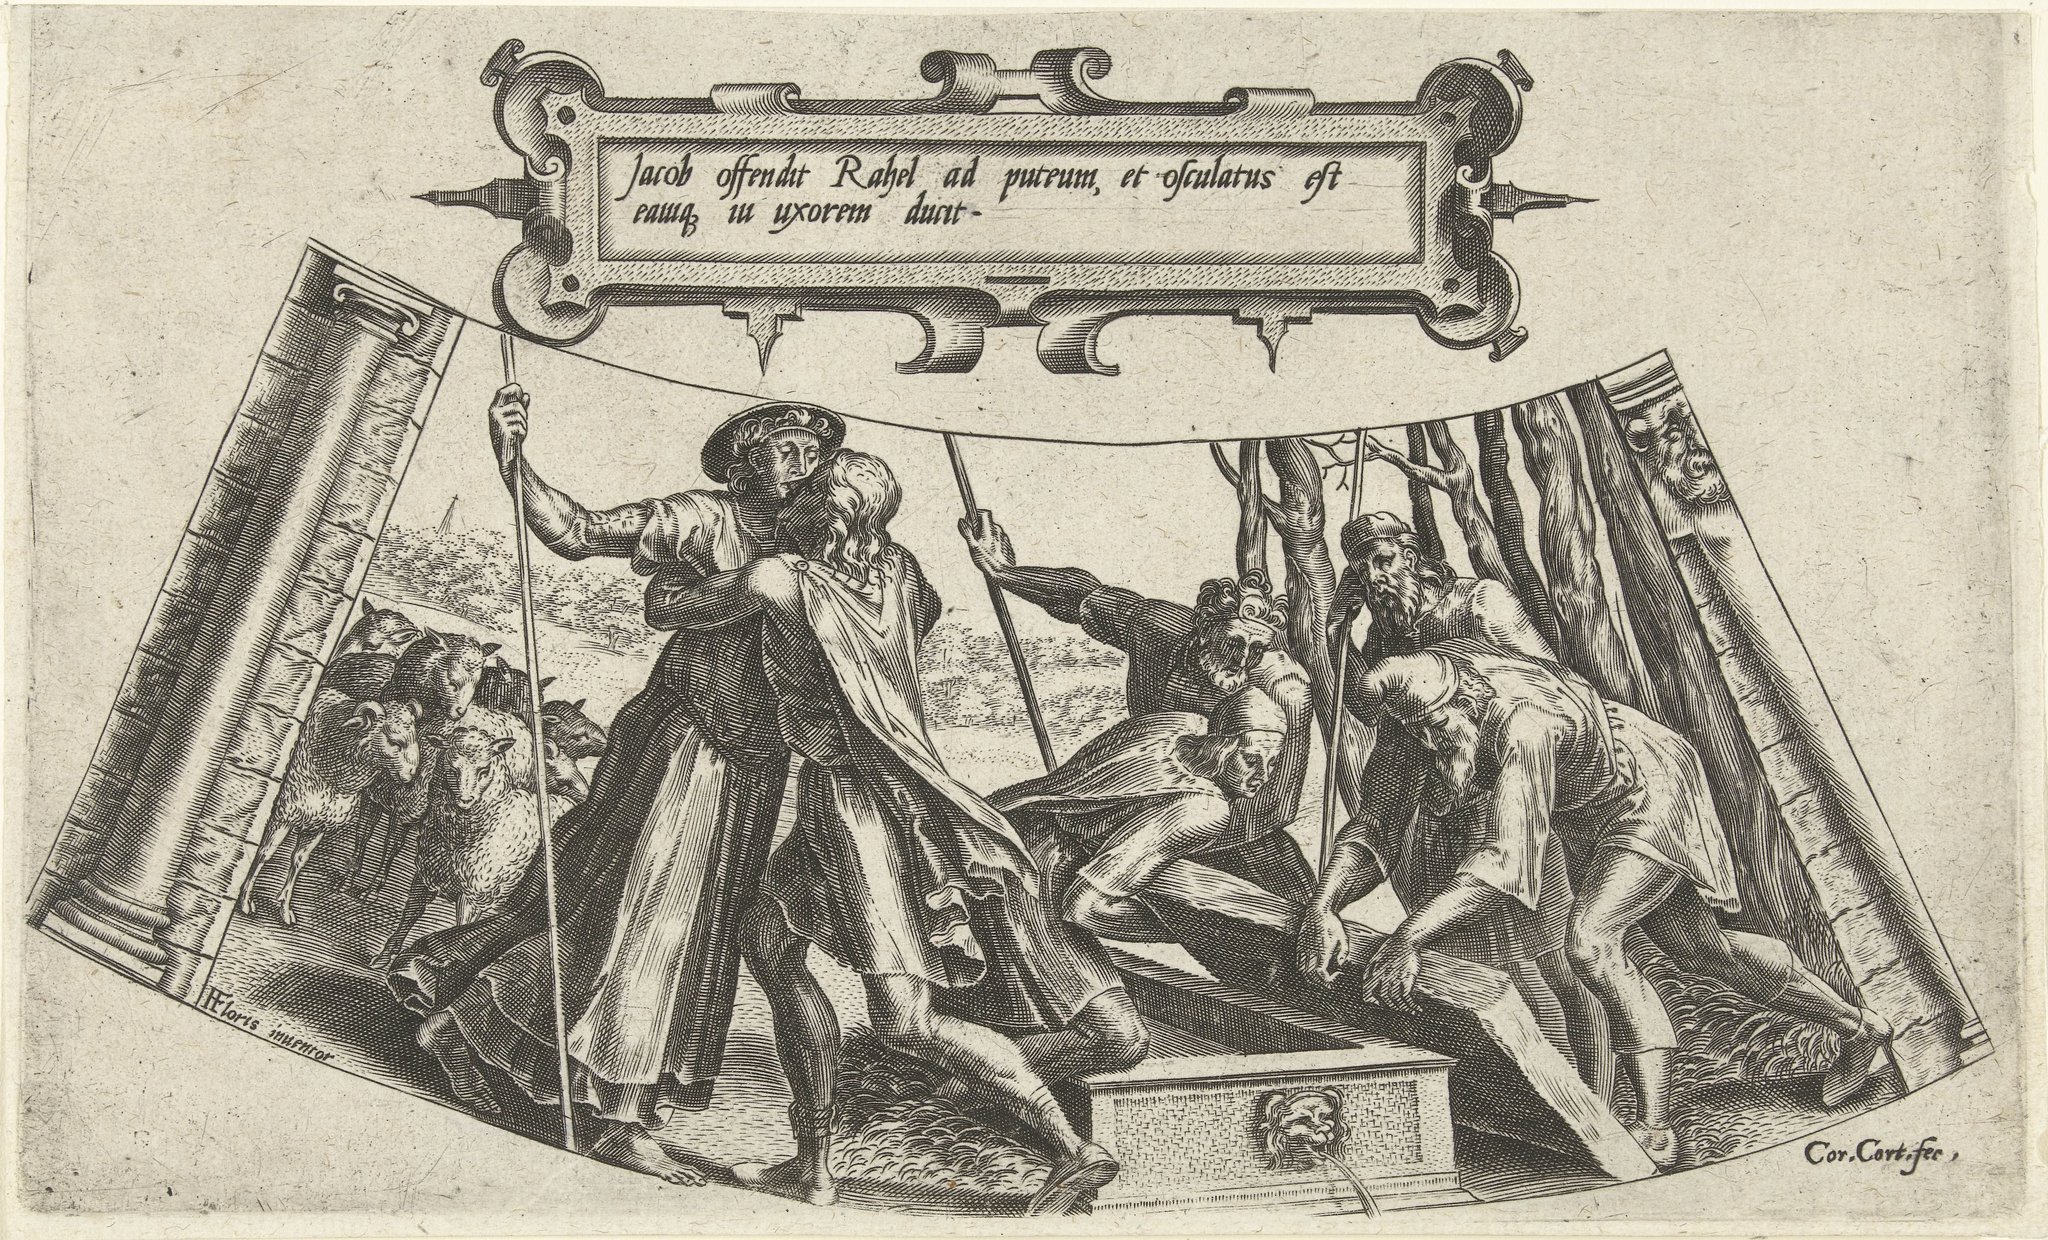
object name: ornament print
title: De ontmoeting van Jakob en Rachel bij de bron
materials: paper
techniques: engraving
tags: ornament ~ cartouche, jacob kisses rachel and is moved to tears, jacob moves the stone which covers the opening of the well and waters rachel's sheep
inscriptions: caption: ‘Jacob offendit Rahel ad puteum, et osculatus est / eamque in uxorem ducit.’, signature: ‘Cor Cort fec’, collector's mark: Lugt 2228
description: Ornament voor een schotelrand. Jakob en Rachel omhelzen elkaar bij de waterput van Haran. Rachel was bezig de schapen van haar vader te drenken. Jakob's mannen verwijderen de steen van de put voor haar. Met Latijnse tekst in cartouches. Met tekst in latijn in cartouche boven de voorstelling.